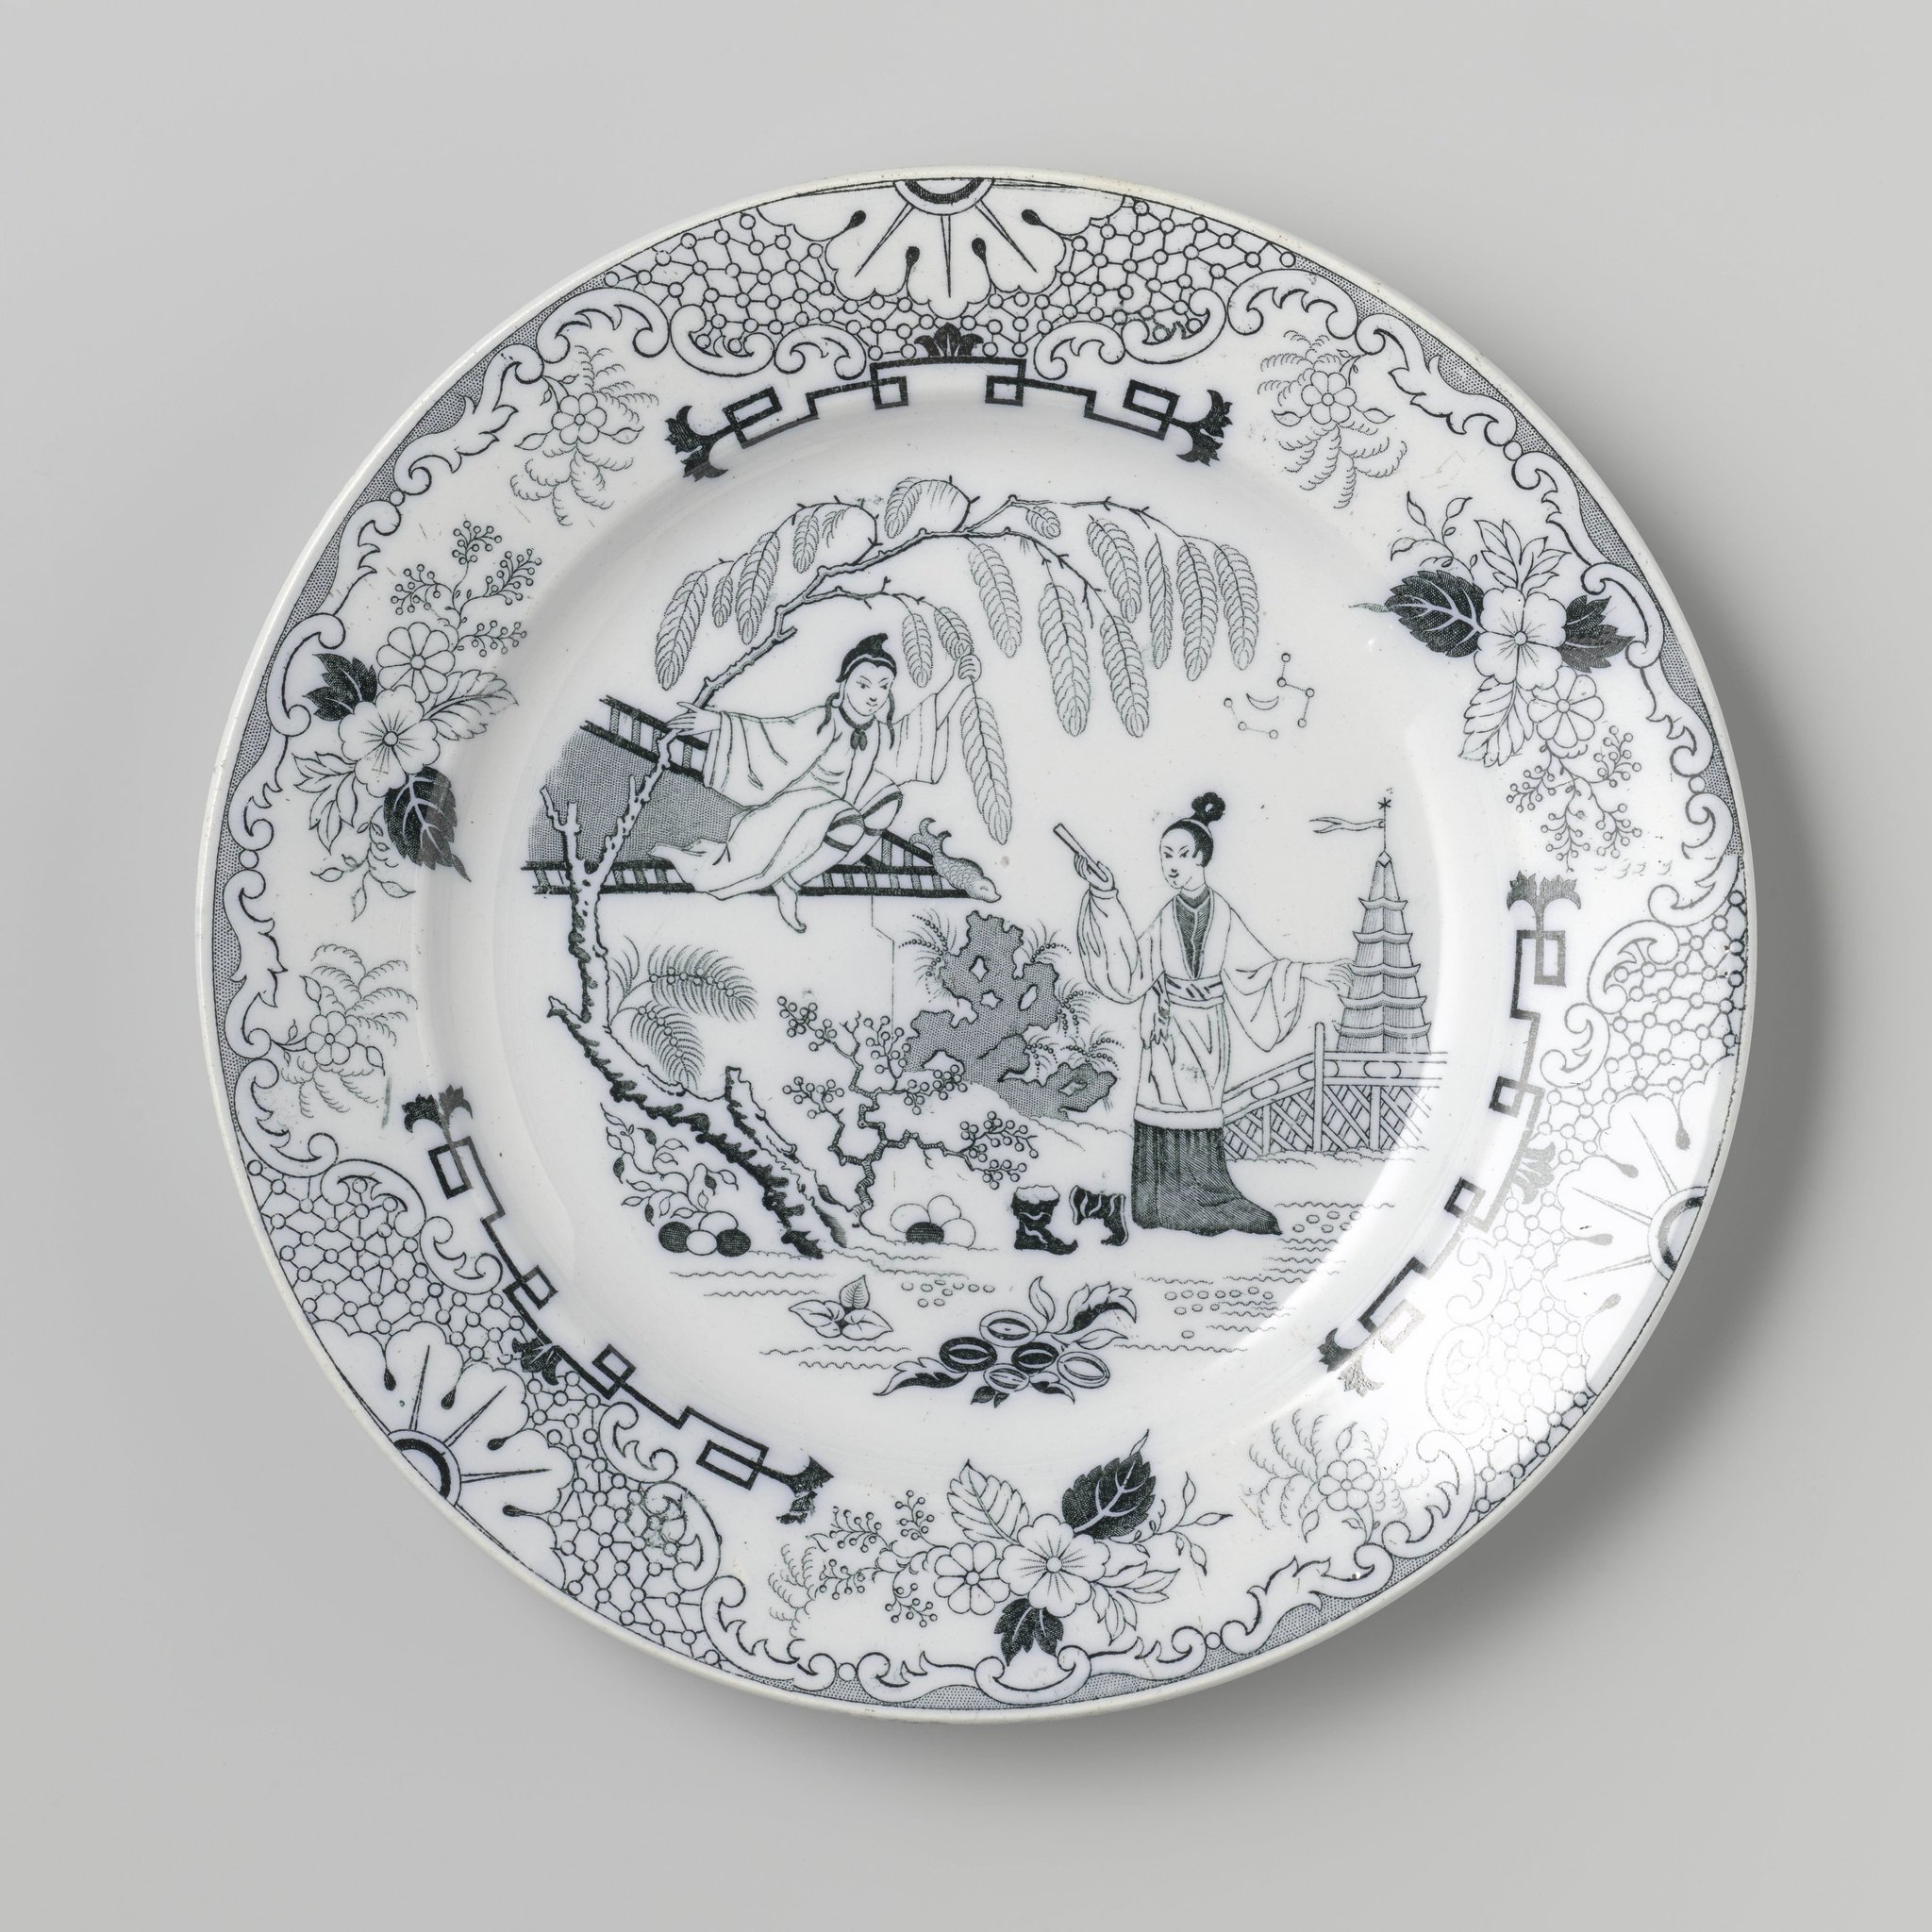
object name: plate dish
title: Bord met op het plat een man op het dak van een huis en een vrouw beneden op de grond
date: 1400-1950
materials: earthenware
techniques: transfer decoration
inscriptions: check stamp: ‘3 1/2 S’, mark: ‘TIMOR // V & B en U’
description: Bord van aardewerk met zwart transferdecor. Op het plat een voorstelling van een man zonder schoenen op het dak van een huis. Benenden op de grond staat een vrouw naast zijn schoenen. Aan de hemel staan de maan en sterren. De rand van het bord met bloemen, voluten en abstracte motieven.